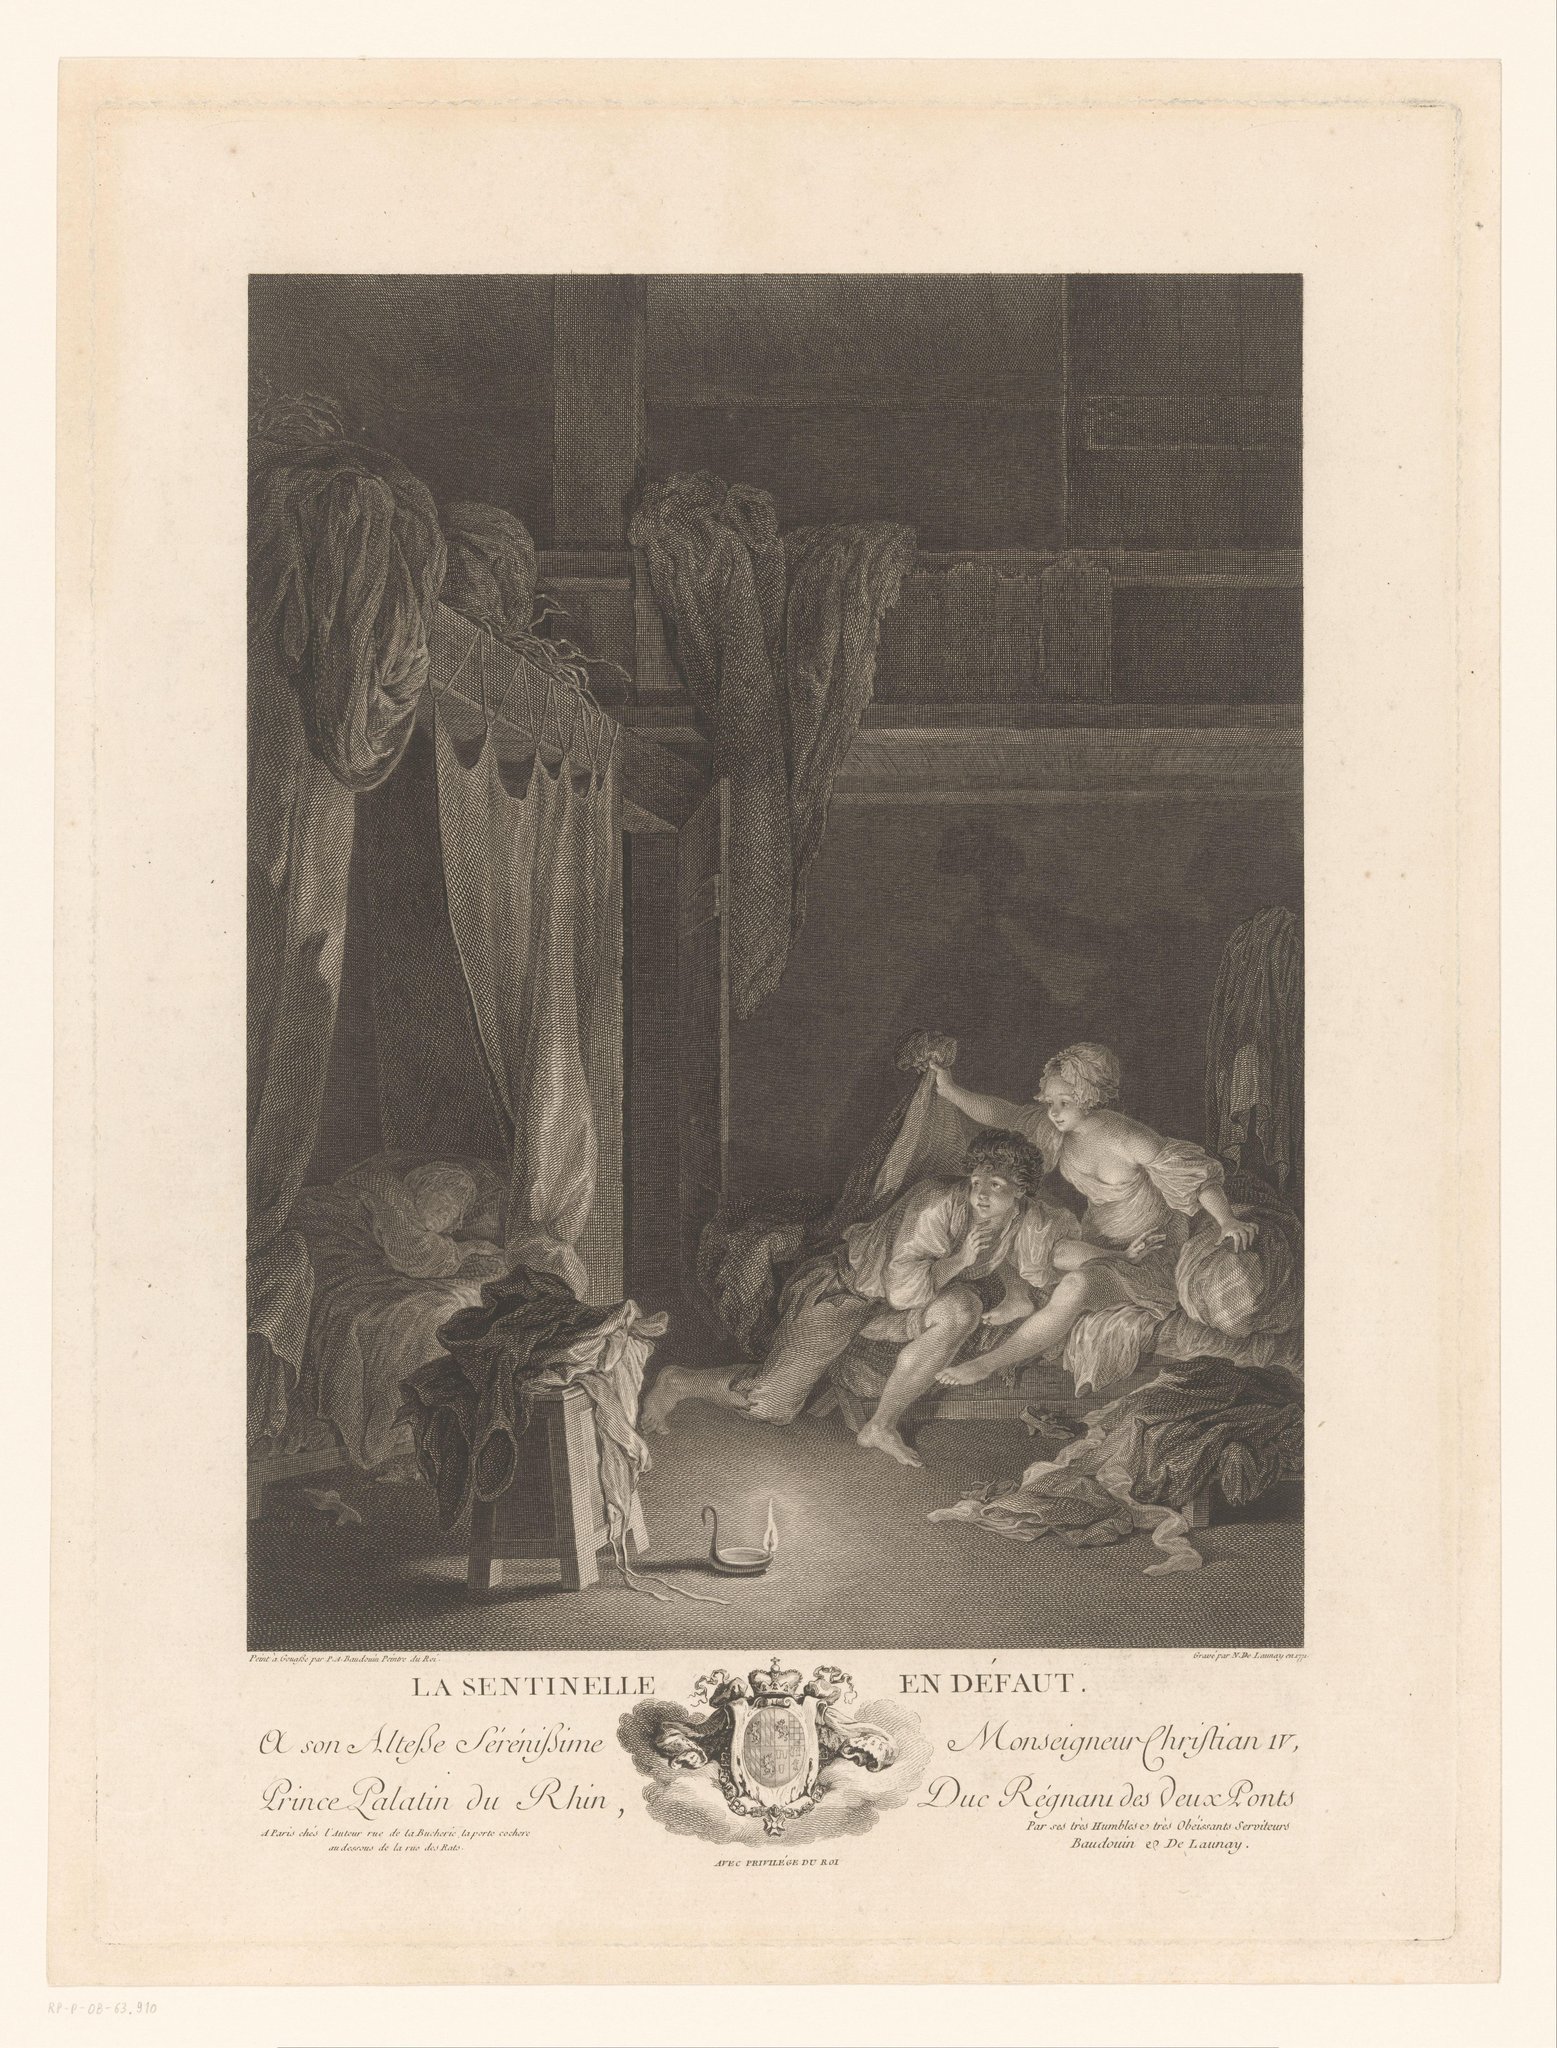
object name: print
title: La sentinelle en défaut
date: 1771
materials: paper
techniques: engraving, etching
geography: france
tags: sleeping in bed, couple of lovers, armorial bearing, heraldry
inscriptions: collector's mark: Lugt 2228